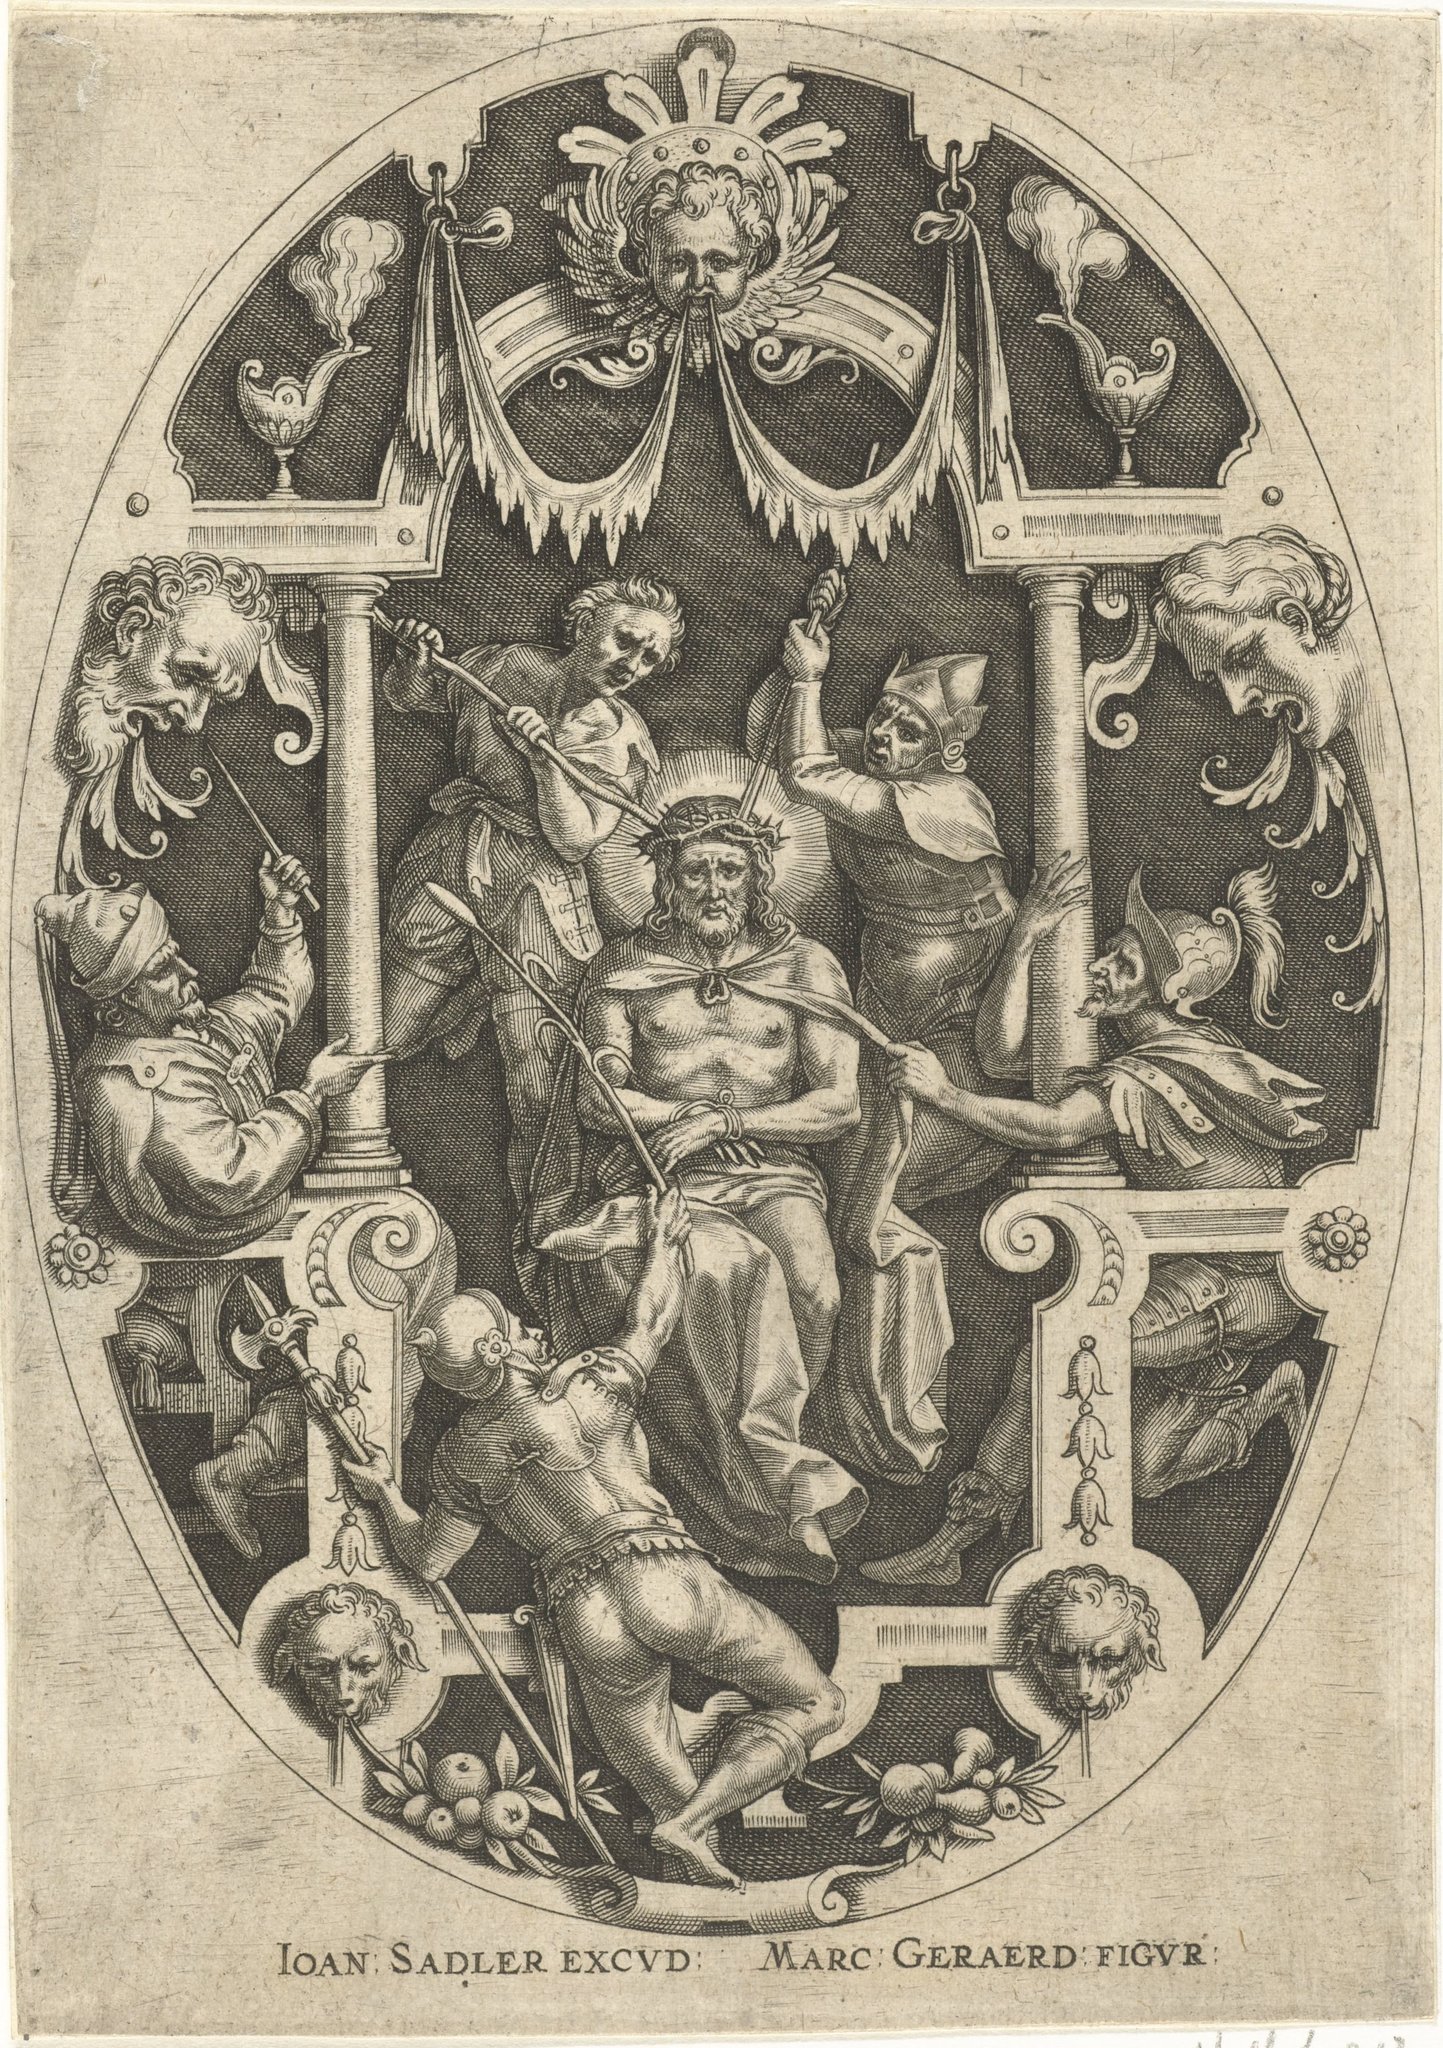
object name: ornament print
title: Passie van Christus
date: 1560-1600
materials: paper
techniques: engraving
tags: ornaments ~ art, the crowning with thorns: soldiers with sticks place a thorny crown on christ's head and give him a reed (matthew 27:27-31; mark 15:16-20; john 19:2-3)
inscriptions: collector's mark: Lugt 2228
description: Christus wordt door de soldaten bespot. Hij krijgt een doornenkroon op zijn hoofd en een grasspriet als scepter. In staand ovaal met ornament. De zesde prent van een dertiendelige serie ornamentprenten over de passie van Christus.